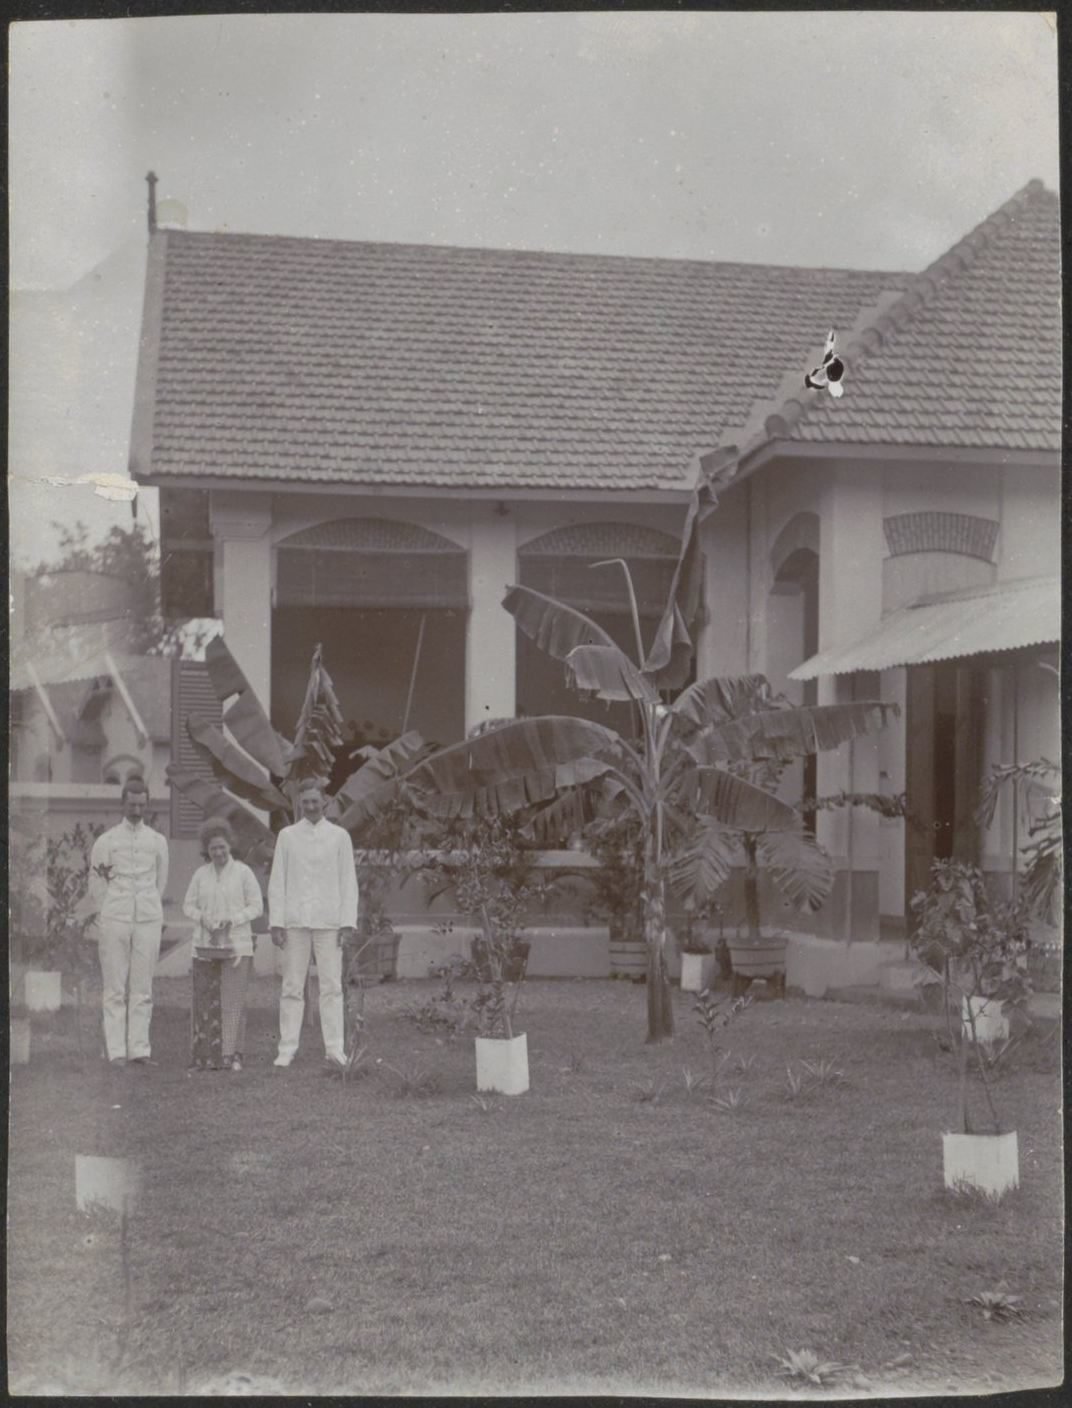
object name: photograph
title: Twee mannen en een vrouw voor een huis in Nederlands-Indië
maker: Anonymous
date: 1930-1949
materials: photographic support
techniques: gelatin silver print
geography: dutch east indies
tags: further education (+ pupil), further education, rural housing, e.g. country-house, villa, cottage, dutch east indies, the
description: Onderdeel van Stamboek van de leerlingen der Koloniale School voor Meisjes en Vrouwen te 's-Gravenhage deel II (1930-1949).